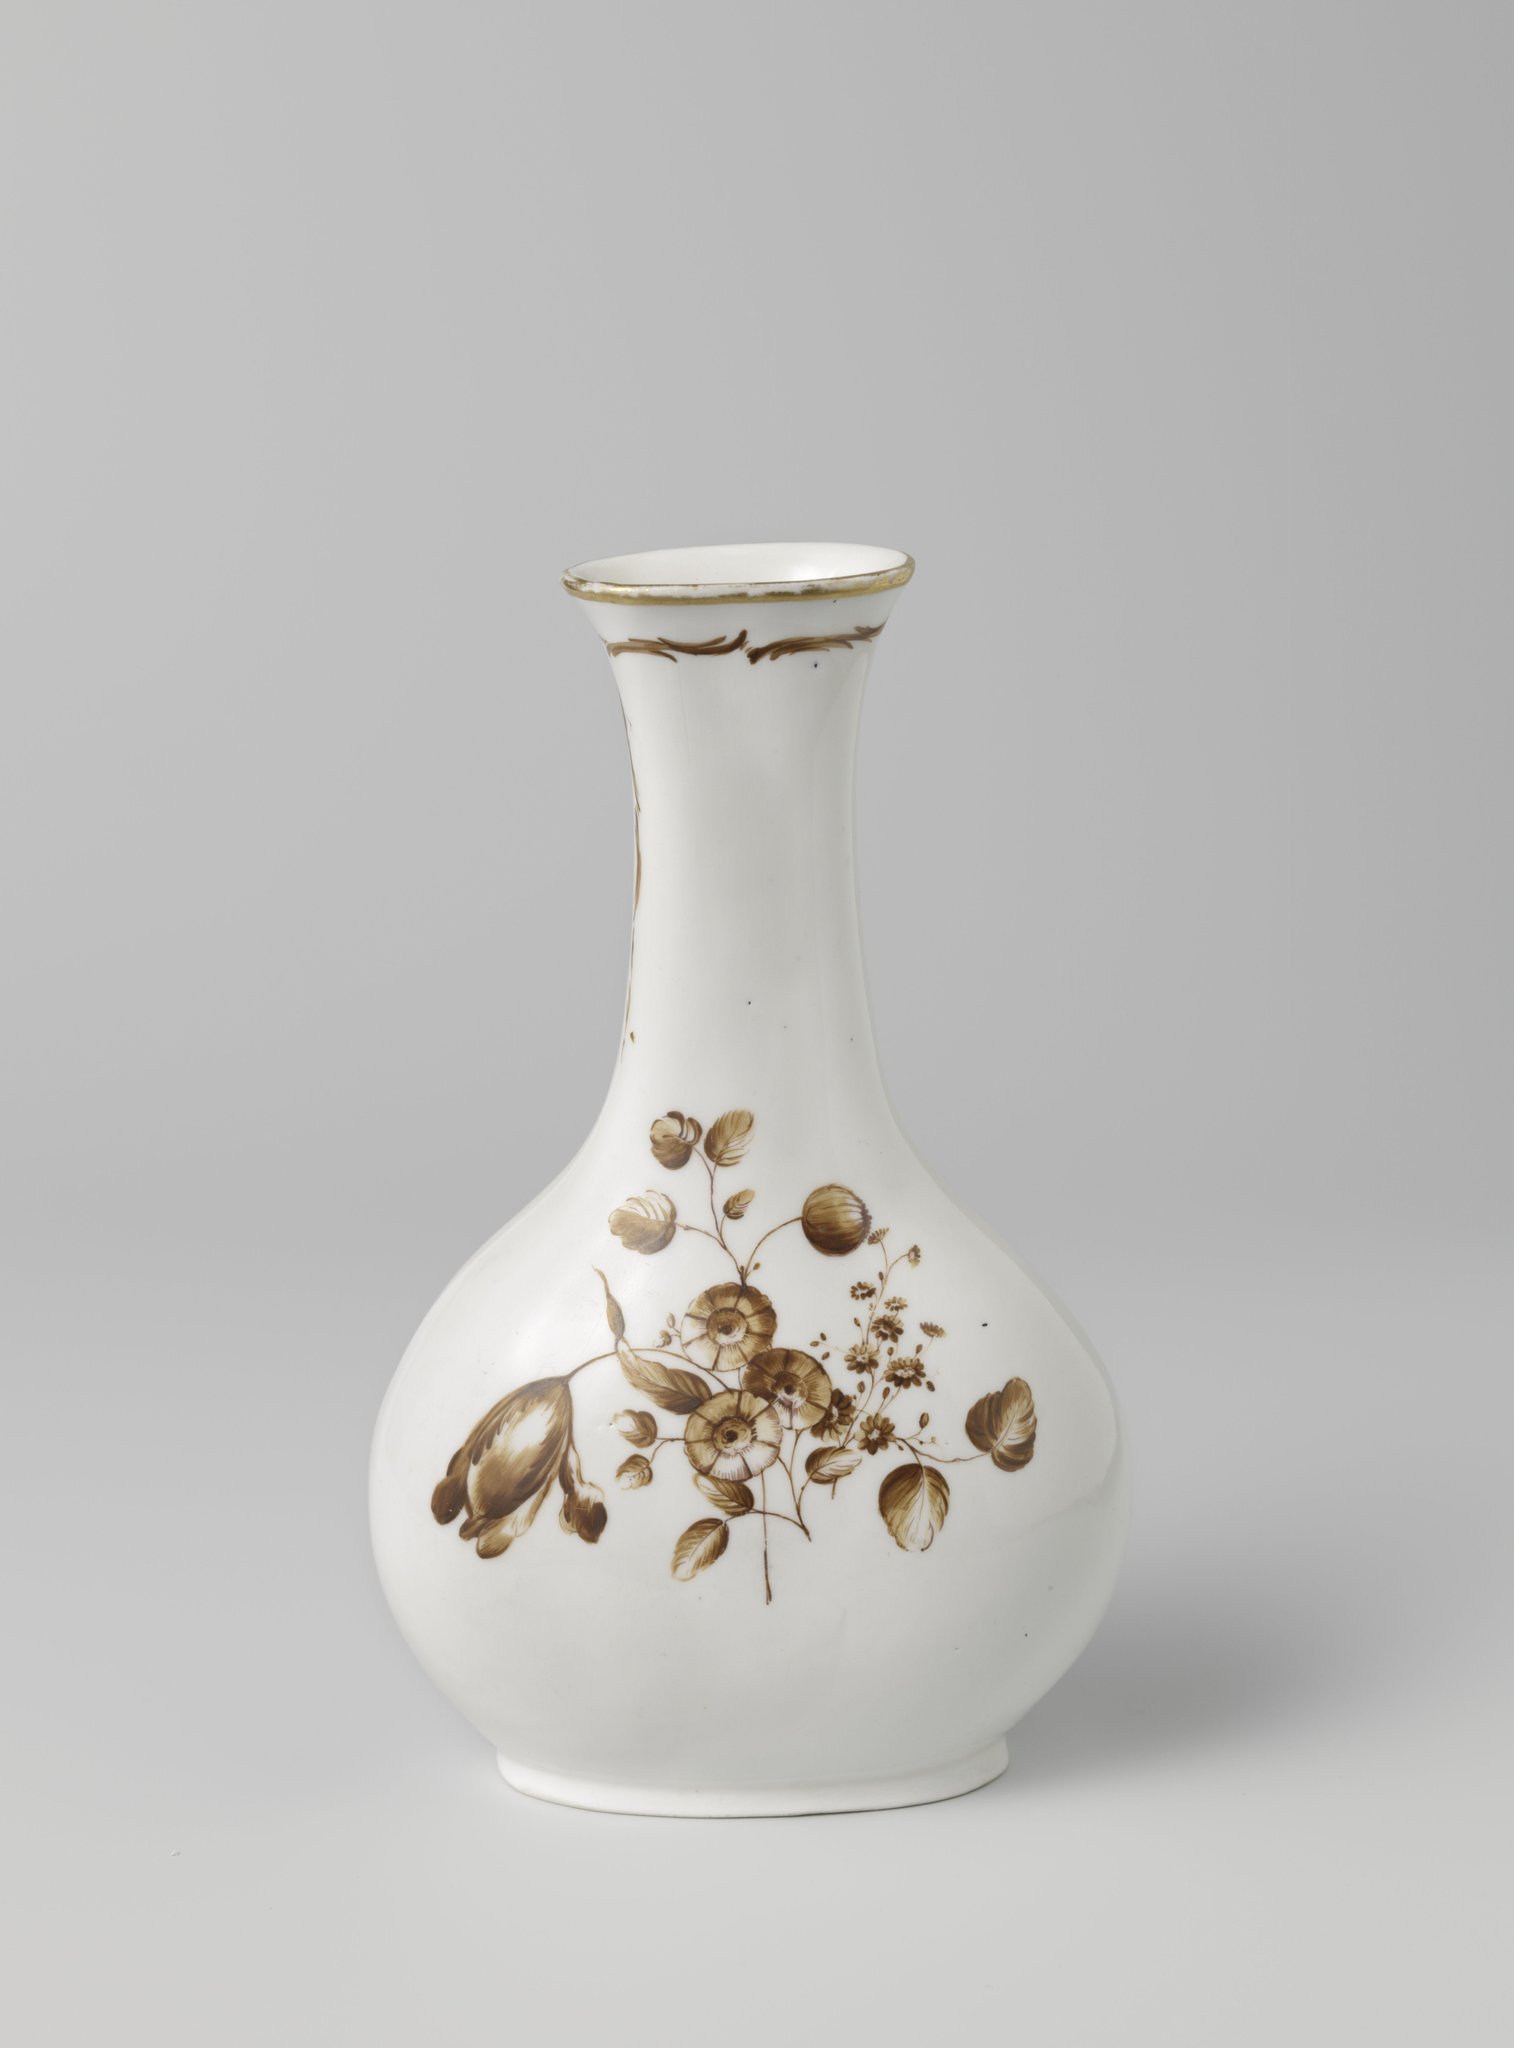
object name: vase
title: Vaas of jachtfles van beschilderd porselein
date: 1774-1784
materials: porcelain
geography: loosdrecht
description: Jachtfles van porselein. De fles heeft een afgeplatte, ellipsvormige buik, die geleidelijk in een hoge hals overgaat. Beschilderd met een bloemboeket in sepia.